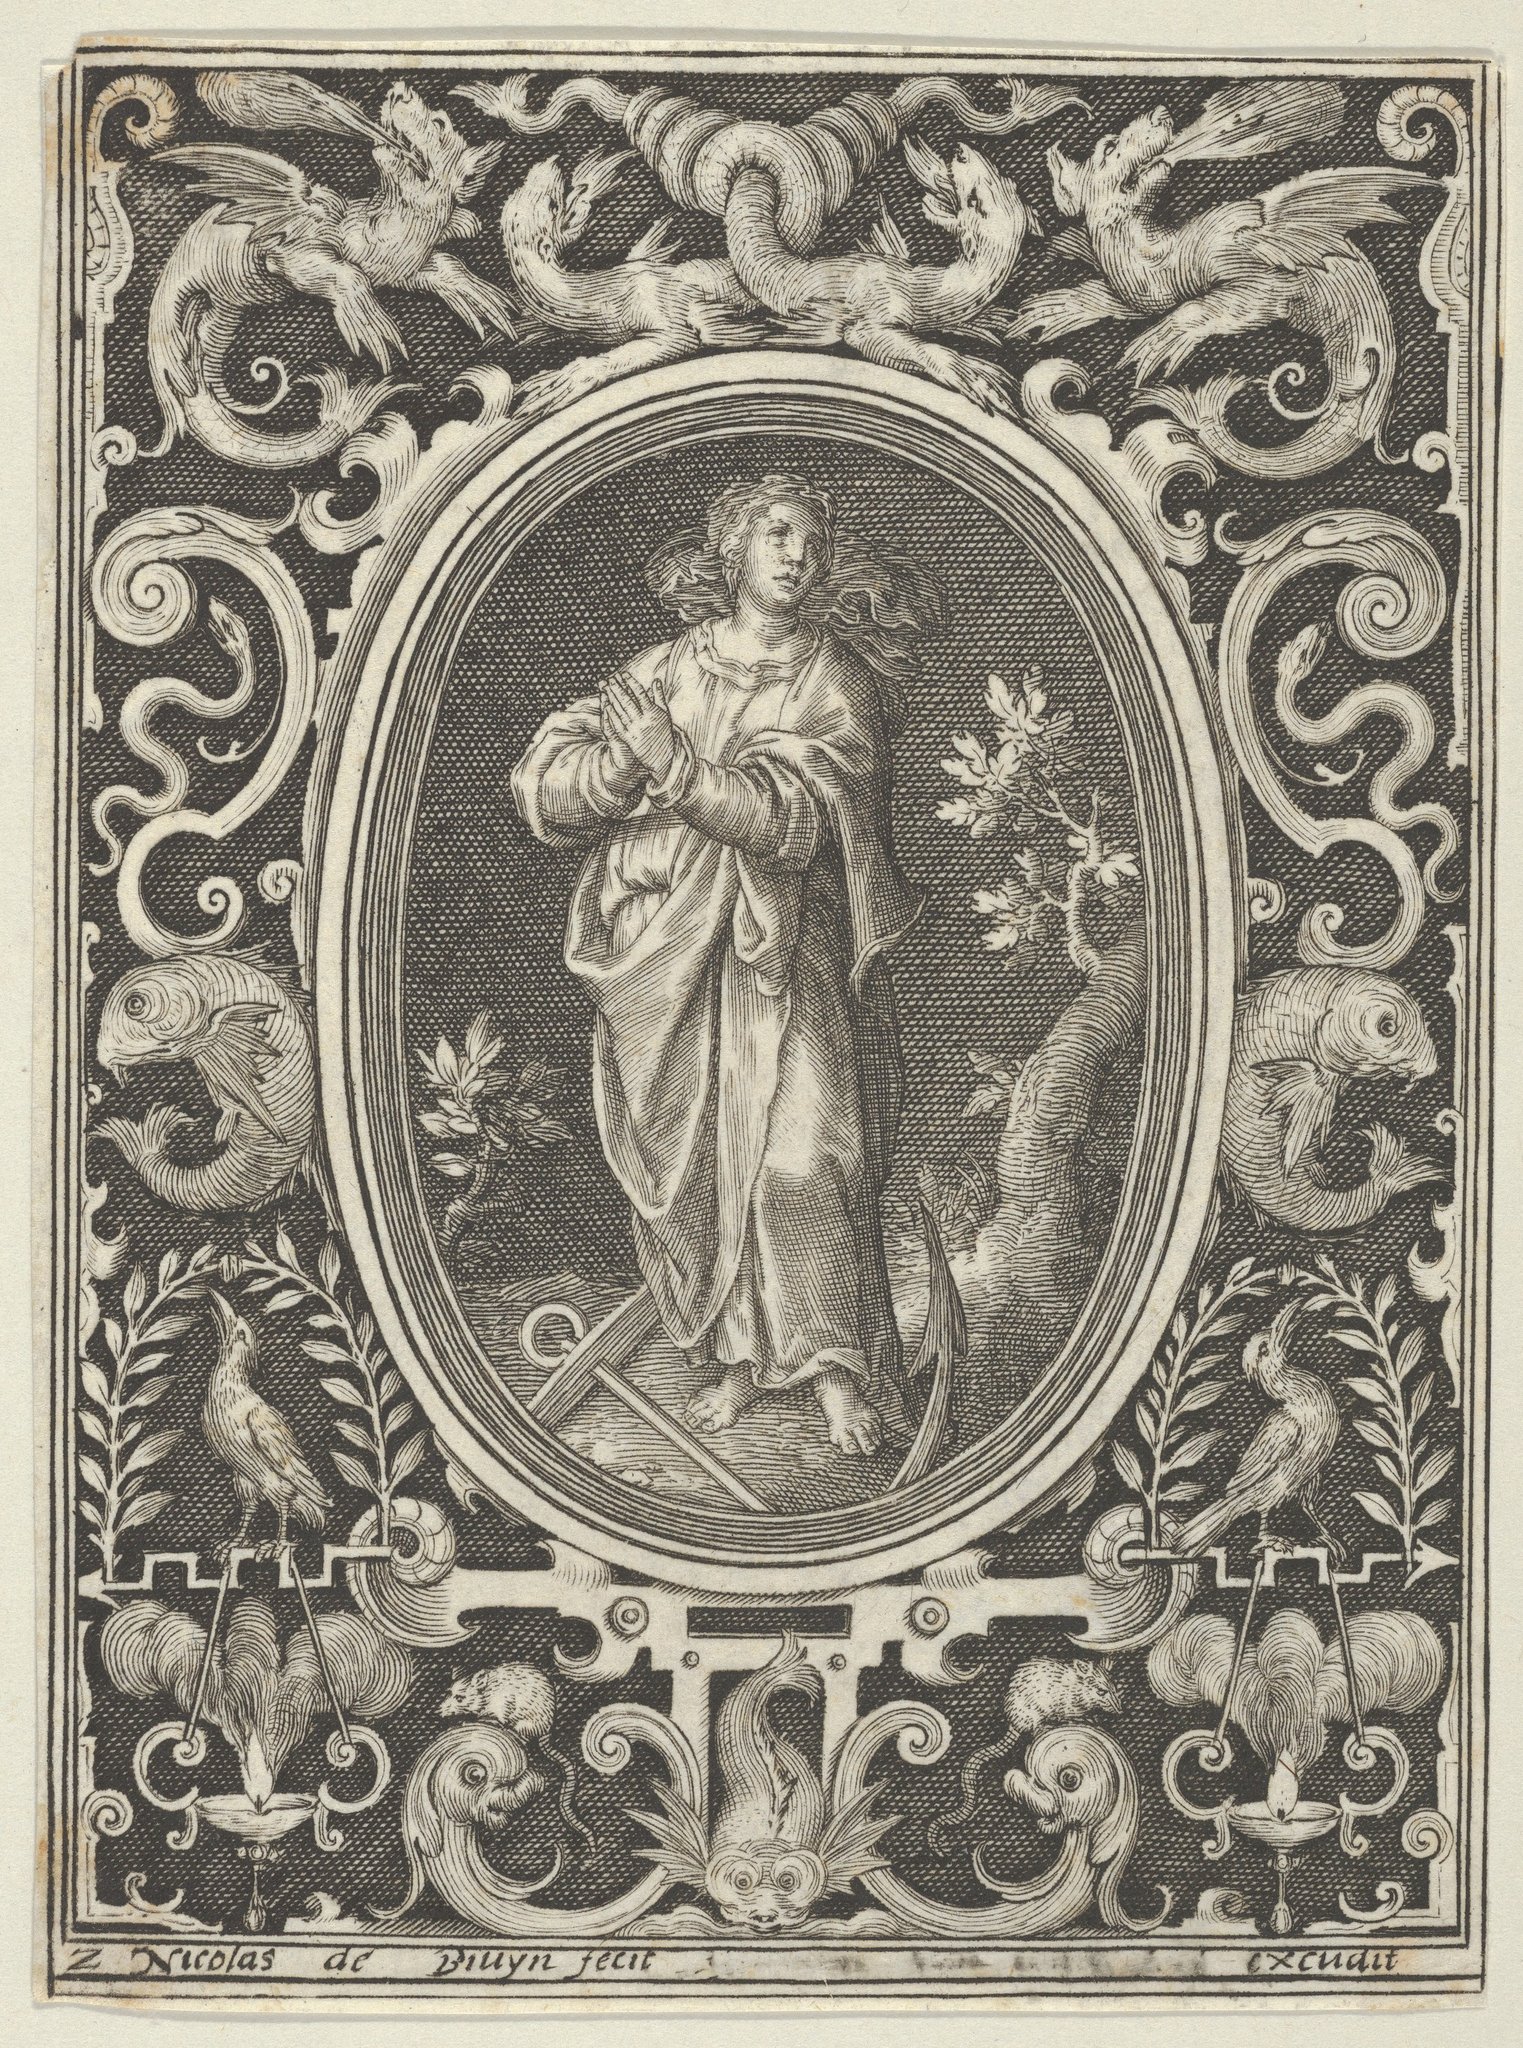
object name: print ornament architecture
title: Hope, from the Cardinal Virtues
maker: nicolaes de bruyn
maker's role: artist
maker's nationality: netherlandish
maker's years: 1571-1656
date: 1648-1656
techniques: engraving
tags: women,dragons,fish,praying